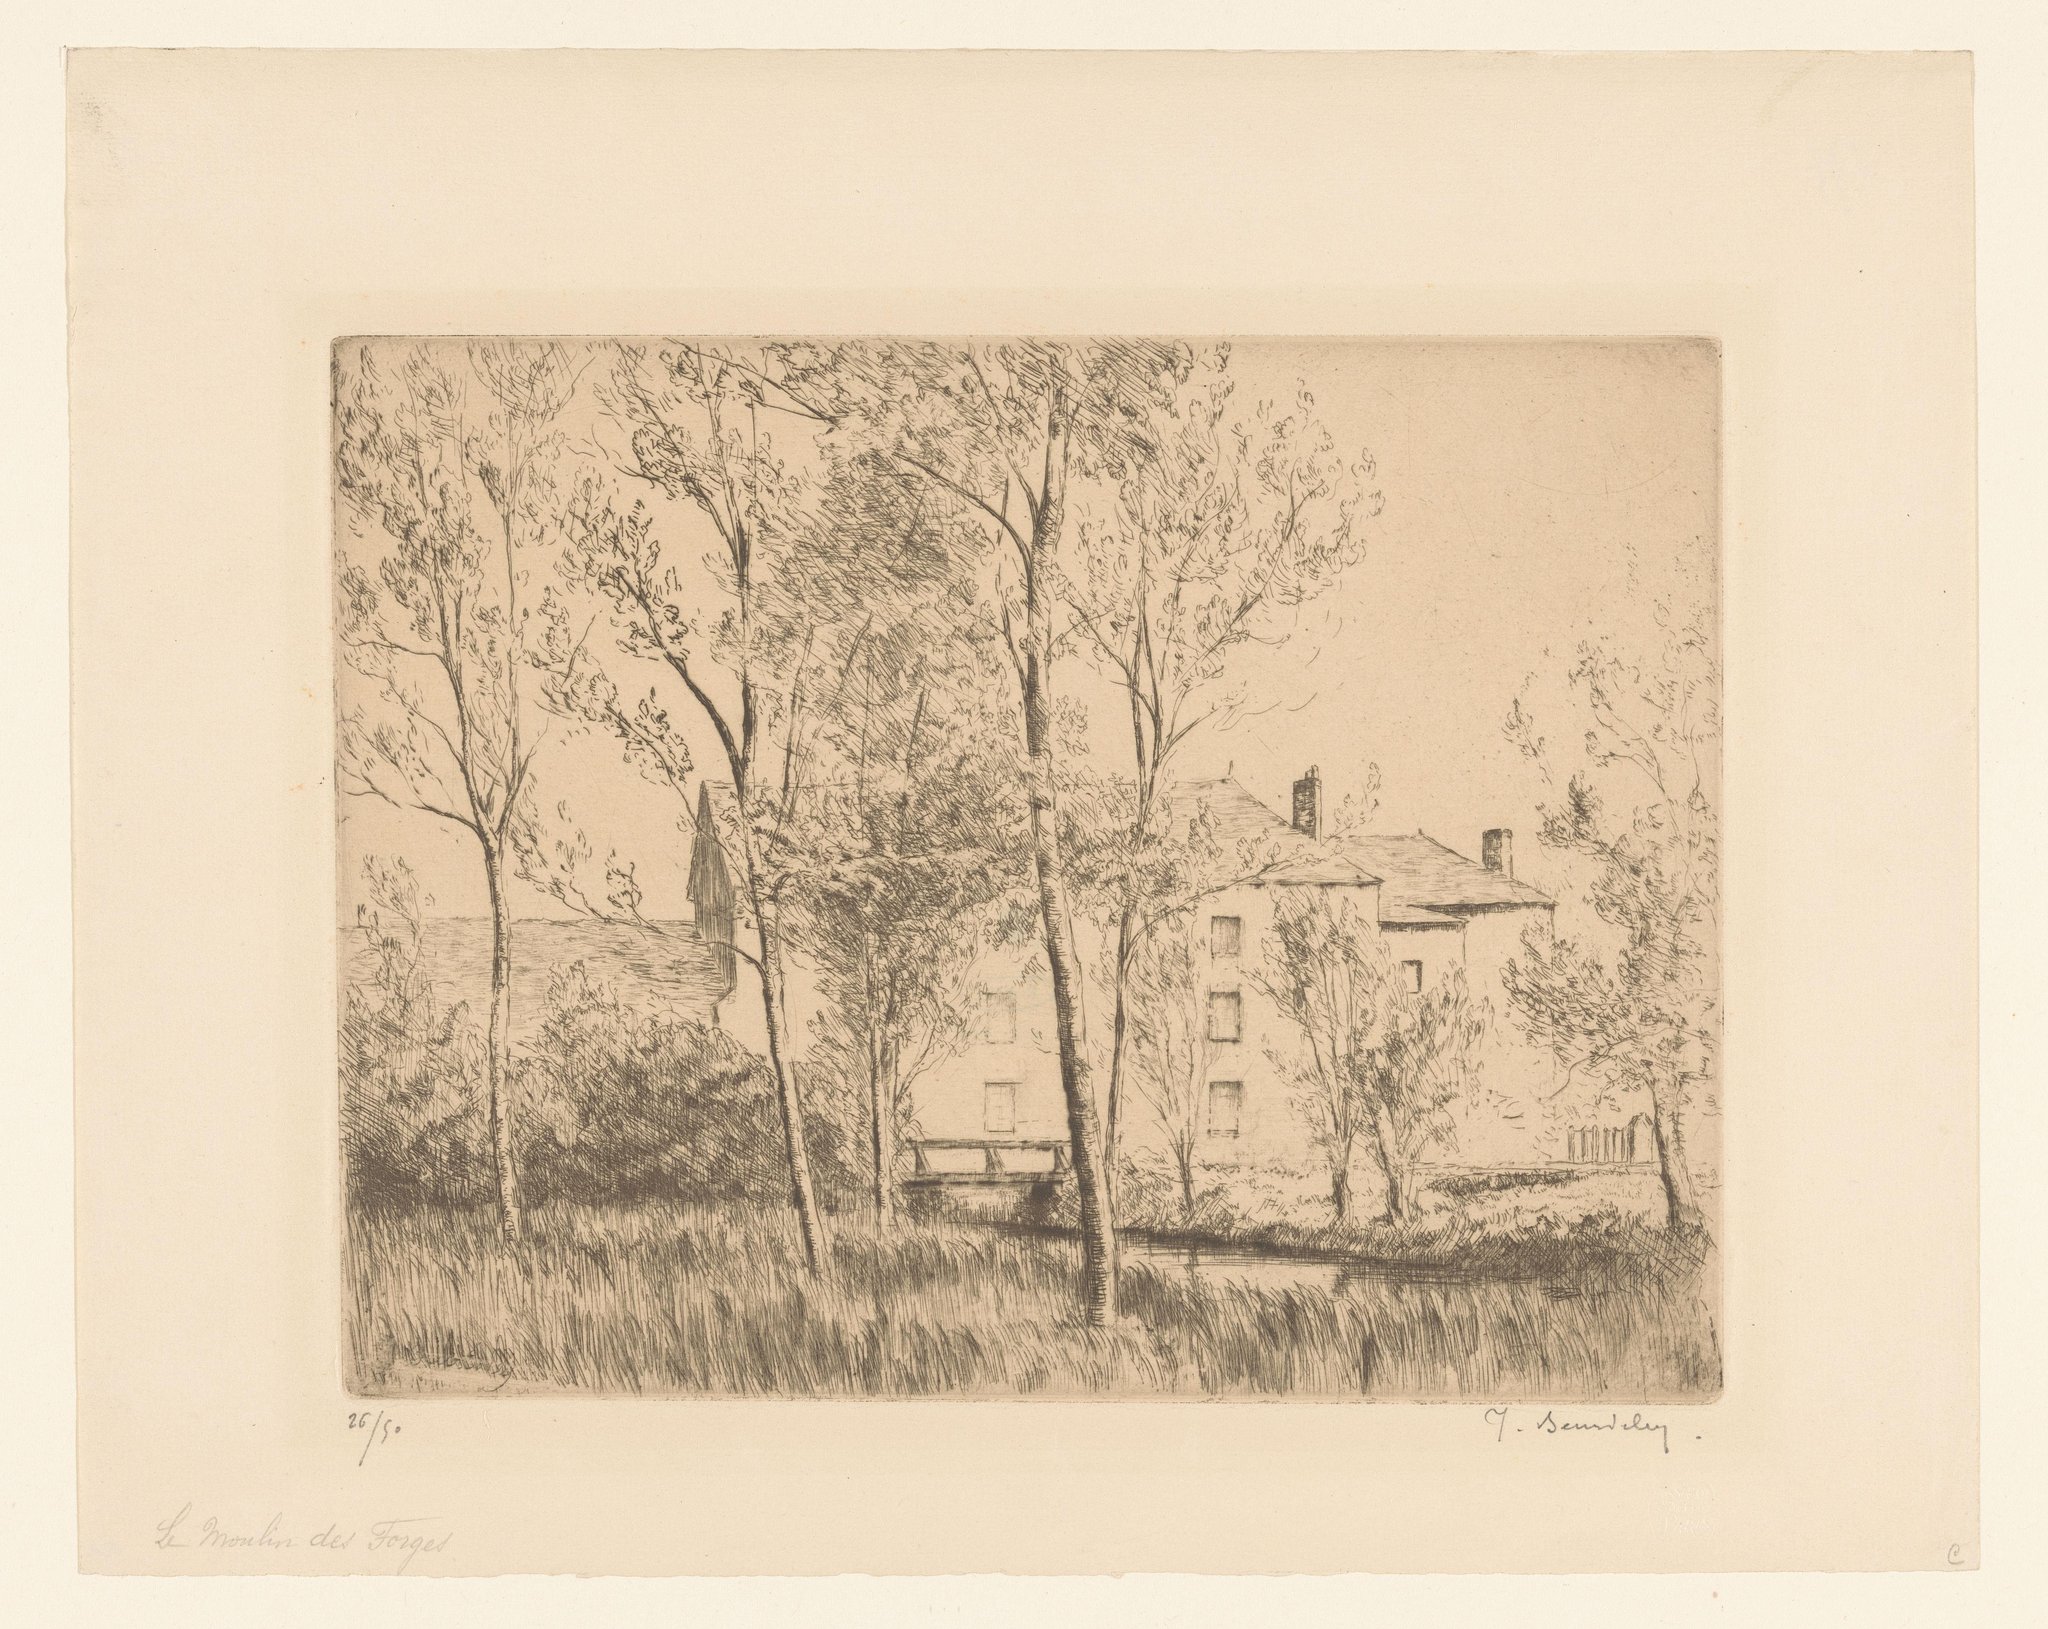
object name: print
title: Landschap met rustiek huis bij een rivier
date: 1919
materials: paper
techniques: etching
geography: paris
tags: river, rural housing, e.g. country-house, villa, cottage, watermill in landscape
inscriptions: collector's mark: Lugt 2228, collector's mark: Lugt 2760, check stamp: Lugt 2254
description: Mogelijk werd de handgeschreven titel op de prent later door iemand anders toegevoegd.